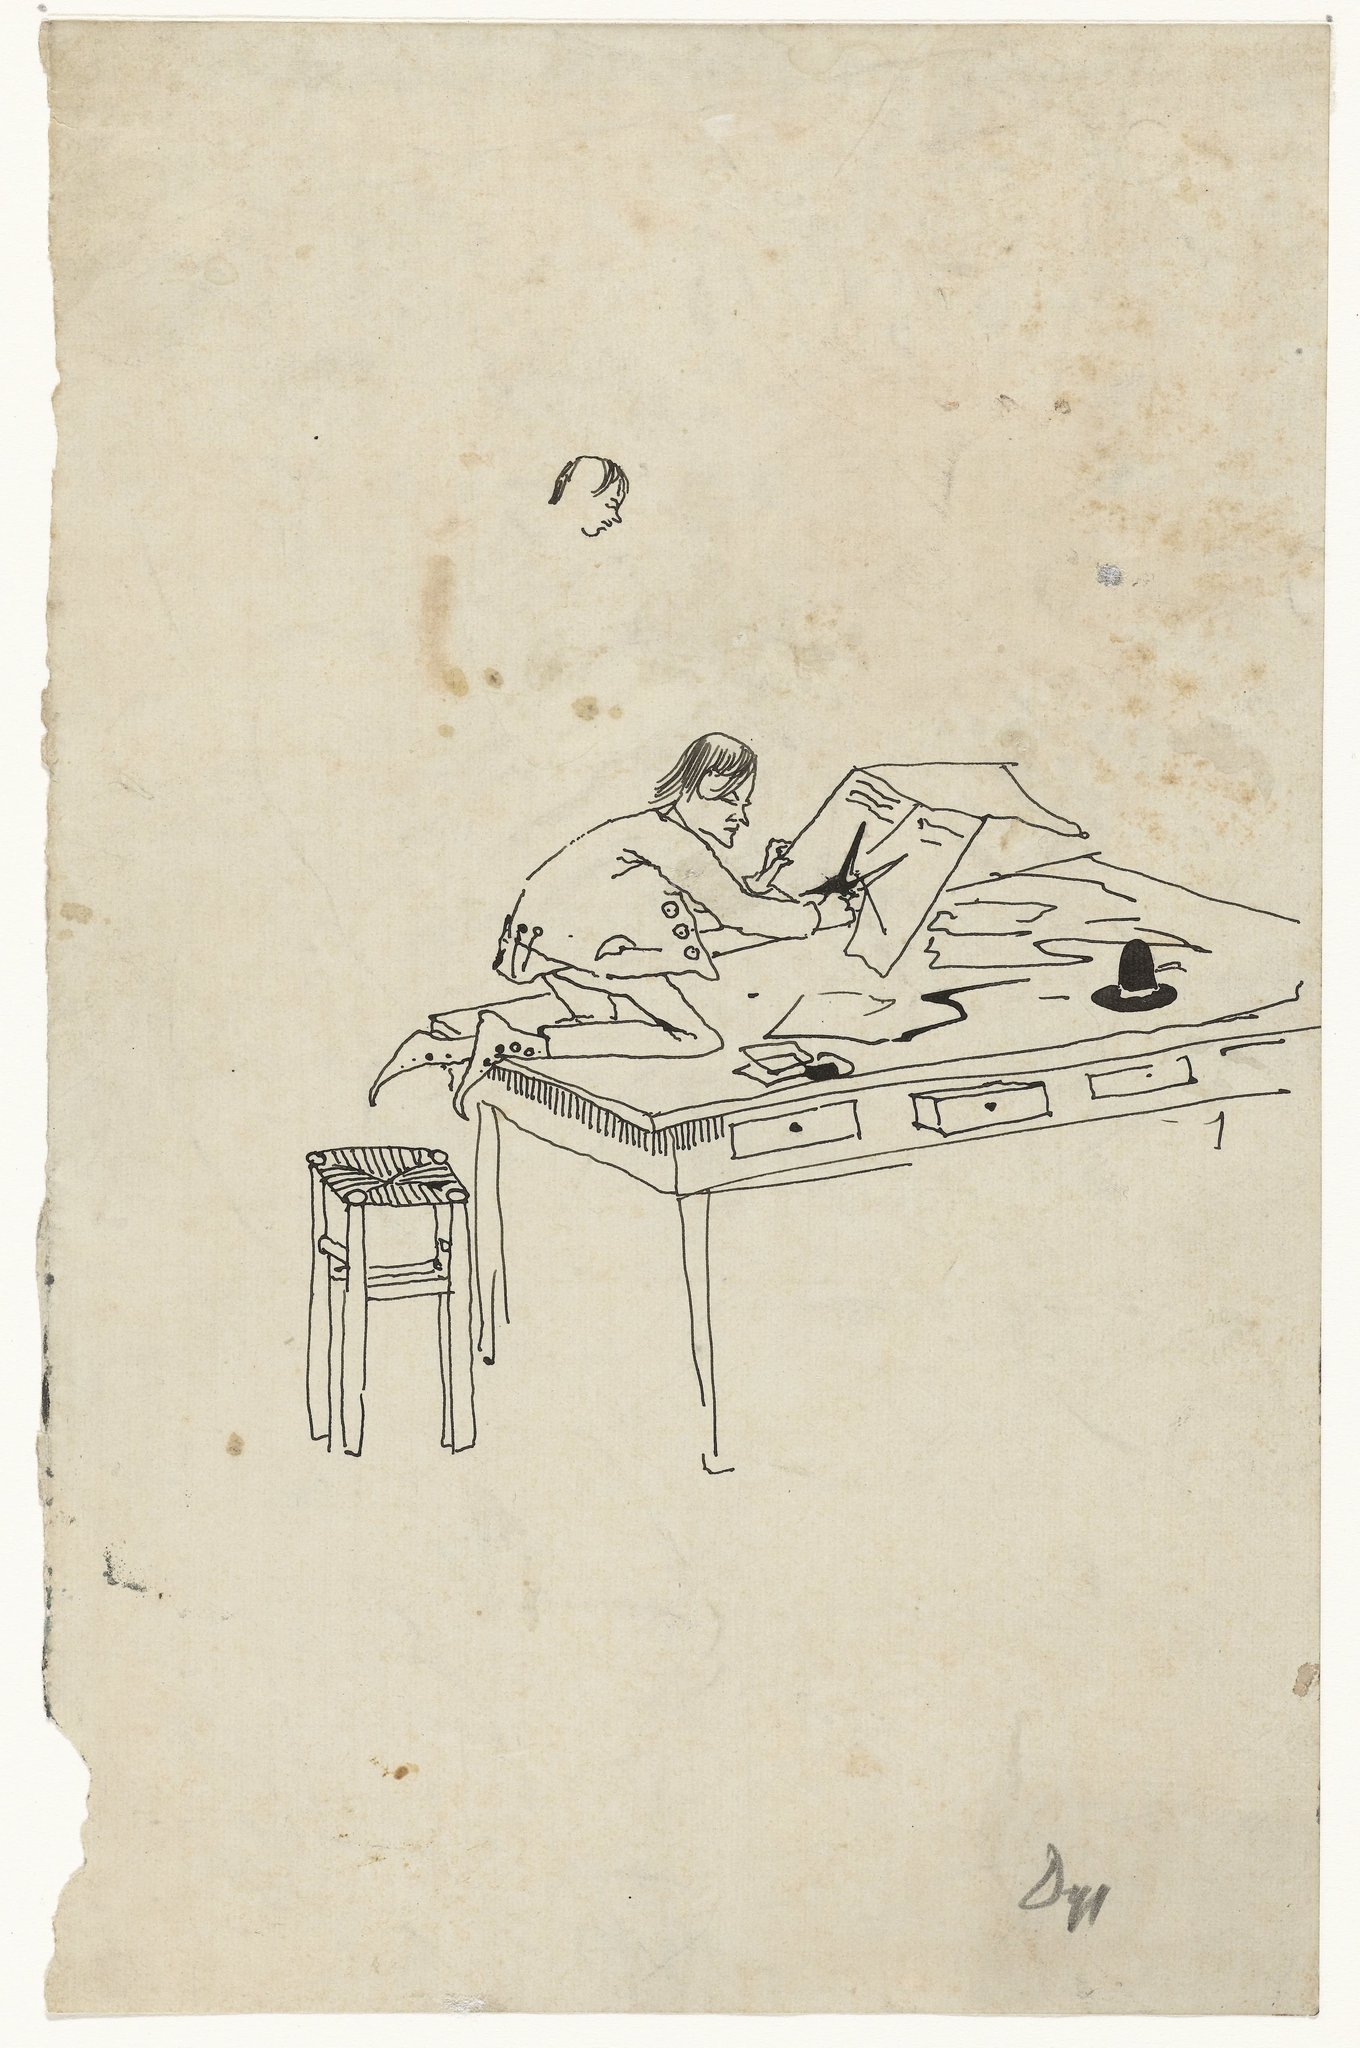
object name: drawing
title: Kabouter knielend knippend op een tafel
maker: gerrit willem dijsselhof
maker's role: designer, draughtsman, print maker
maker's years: 1866-1924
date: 1876-1924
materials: ink, paper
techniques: pen